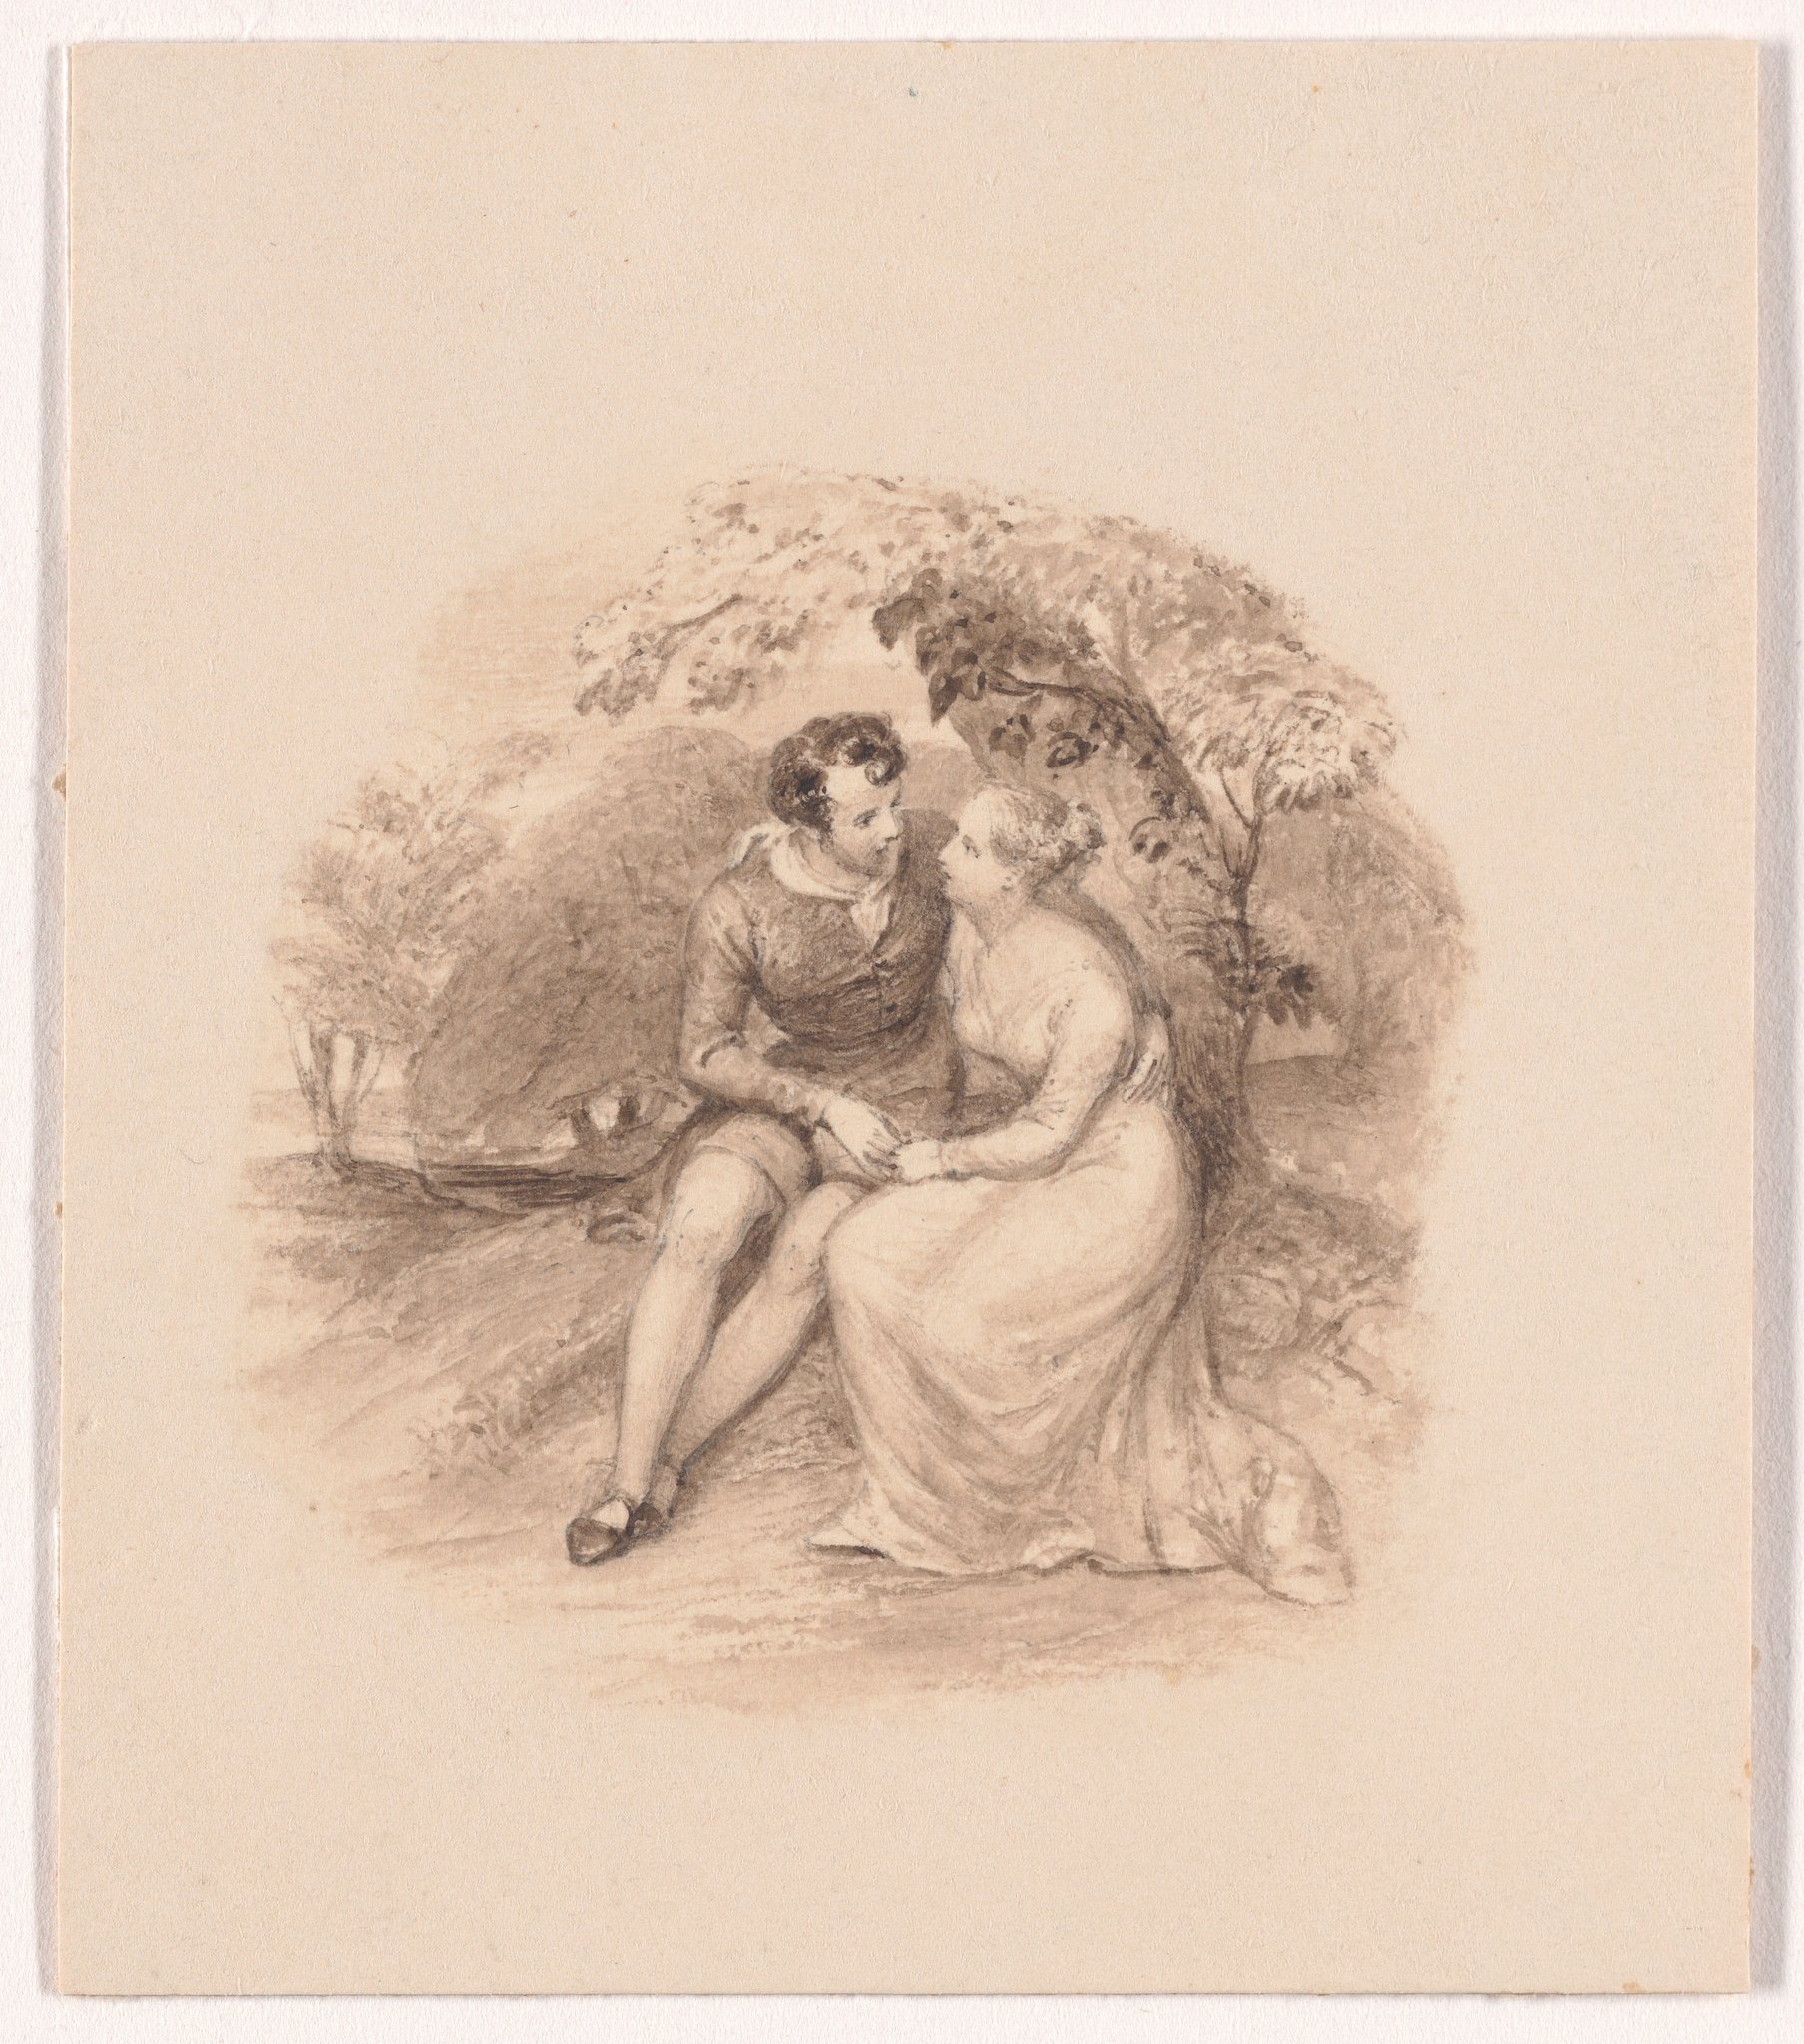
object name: drawing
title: Illustration design for "The Economy of Human Life"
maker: frank howard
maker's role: artist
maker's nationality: british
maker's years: 1805-1866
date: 1834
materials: ink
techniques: brush, pen, wash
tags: couples,men,women